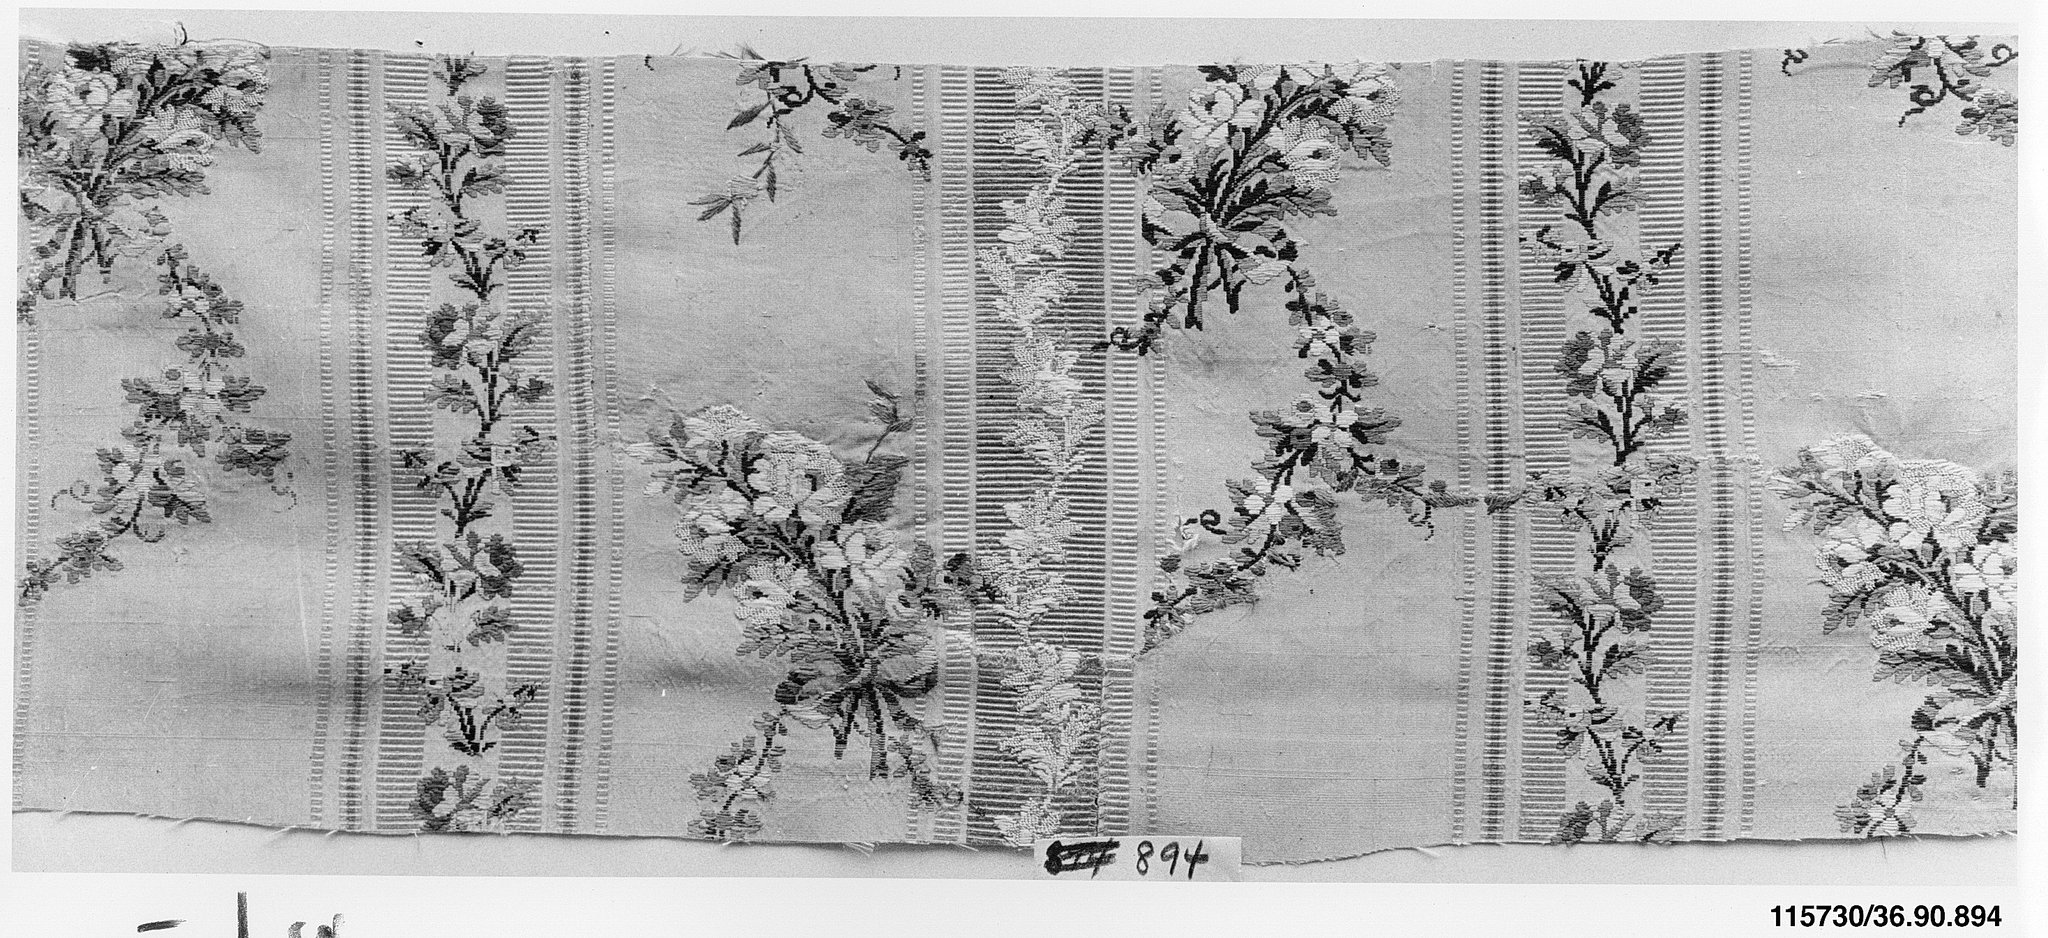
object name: piece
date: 1701-1800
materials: silk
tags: flowers,leaves